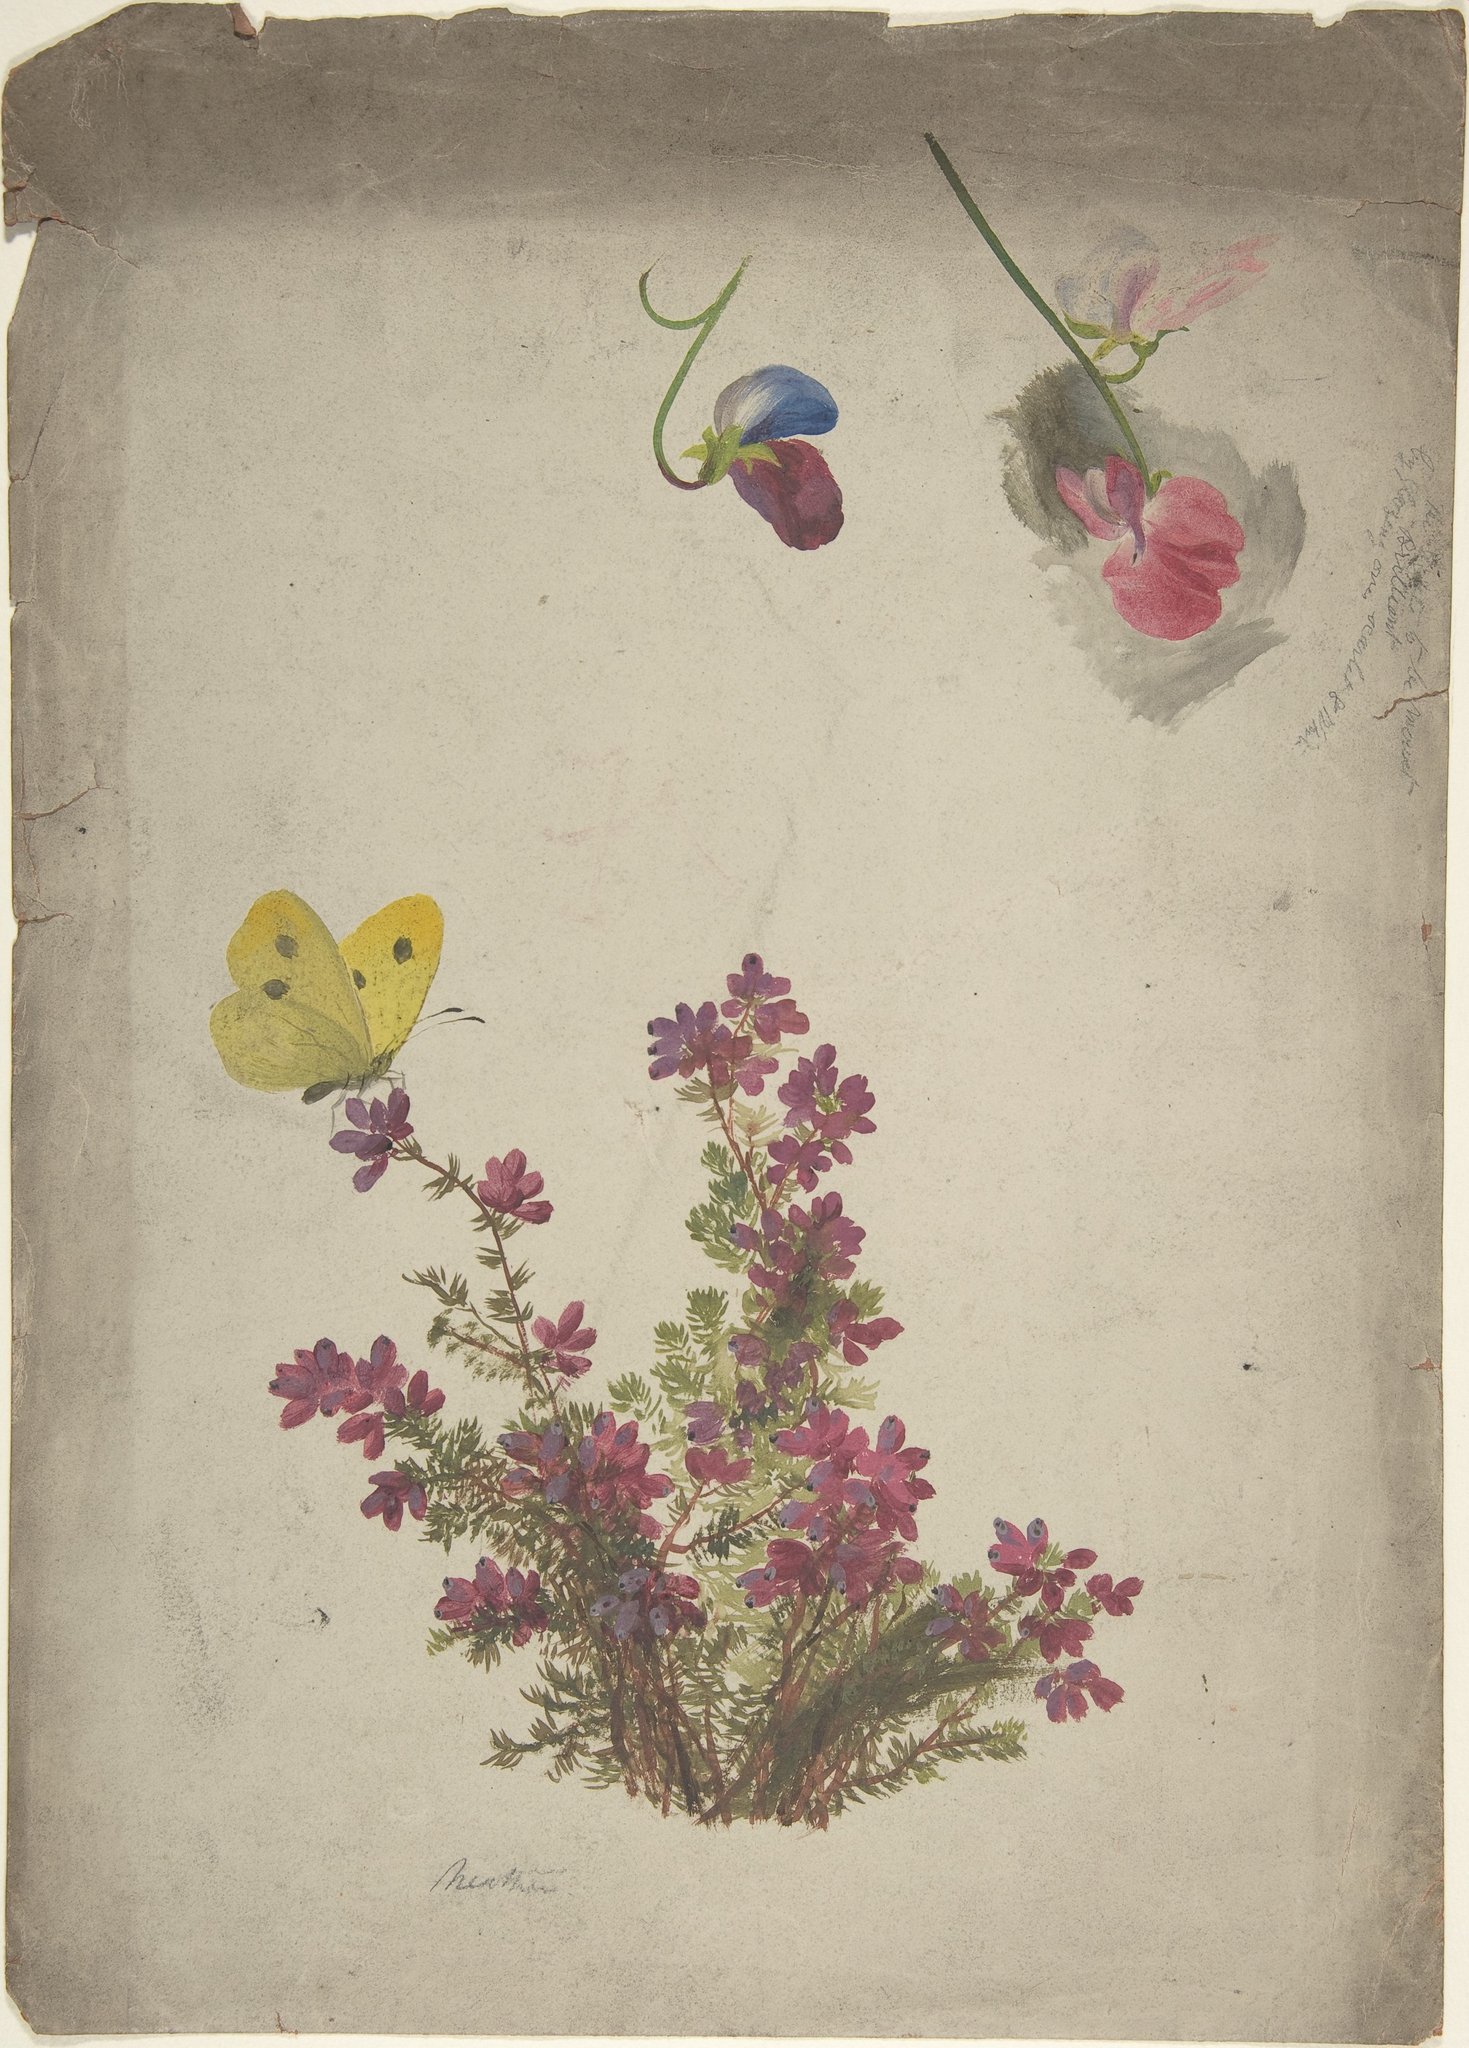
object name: drawing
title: Heather, Sweet Peas and Butterfly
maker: anonymous, british, 19th century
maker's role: artist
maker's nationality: british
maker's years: 1800-1900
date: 1801-1900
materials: gouache, watercolor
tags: butterflies,flowers